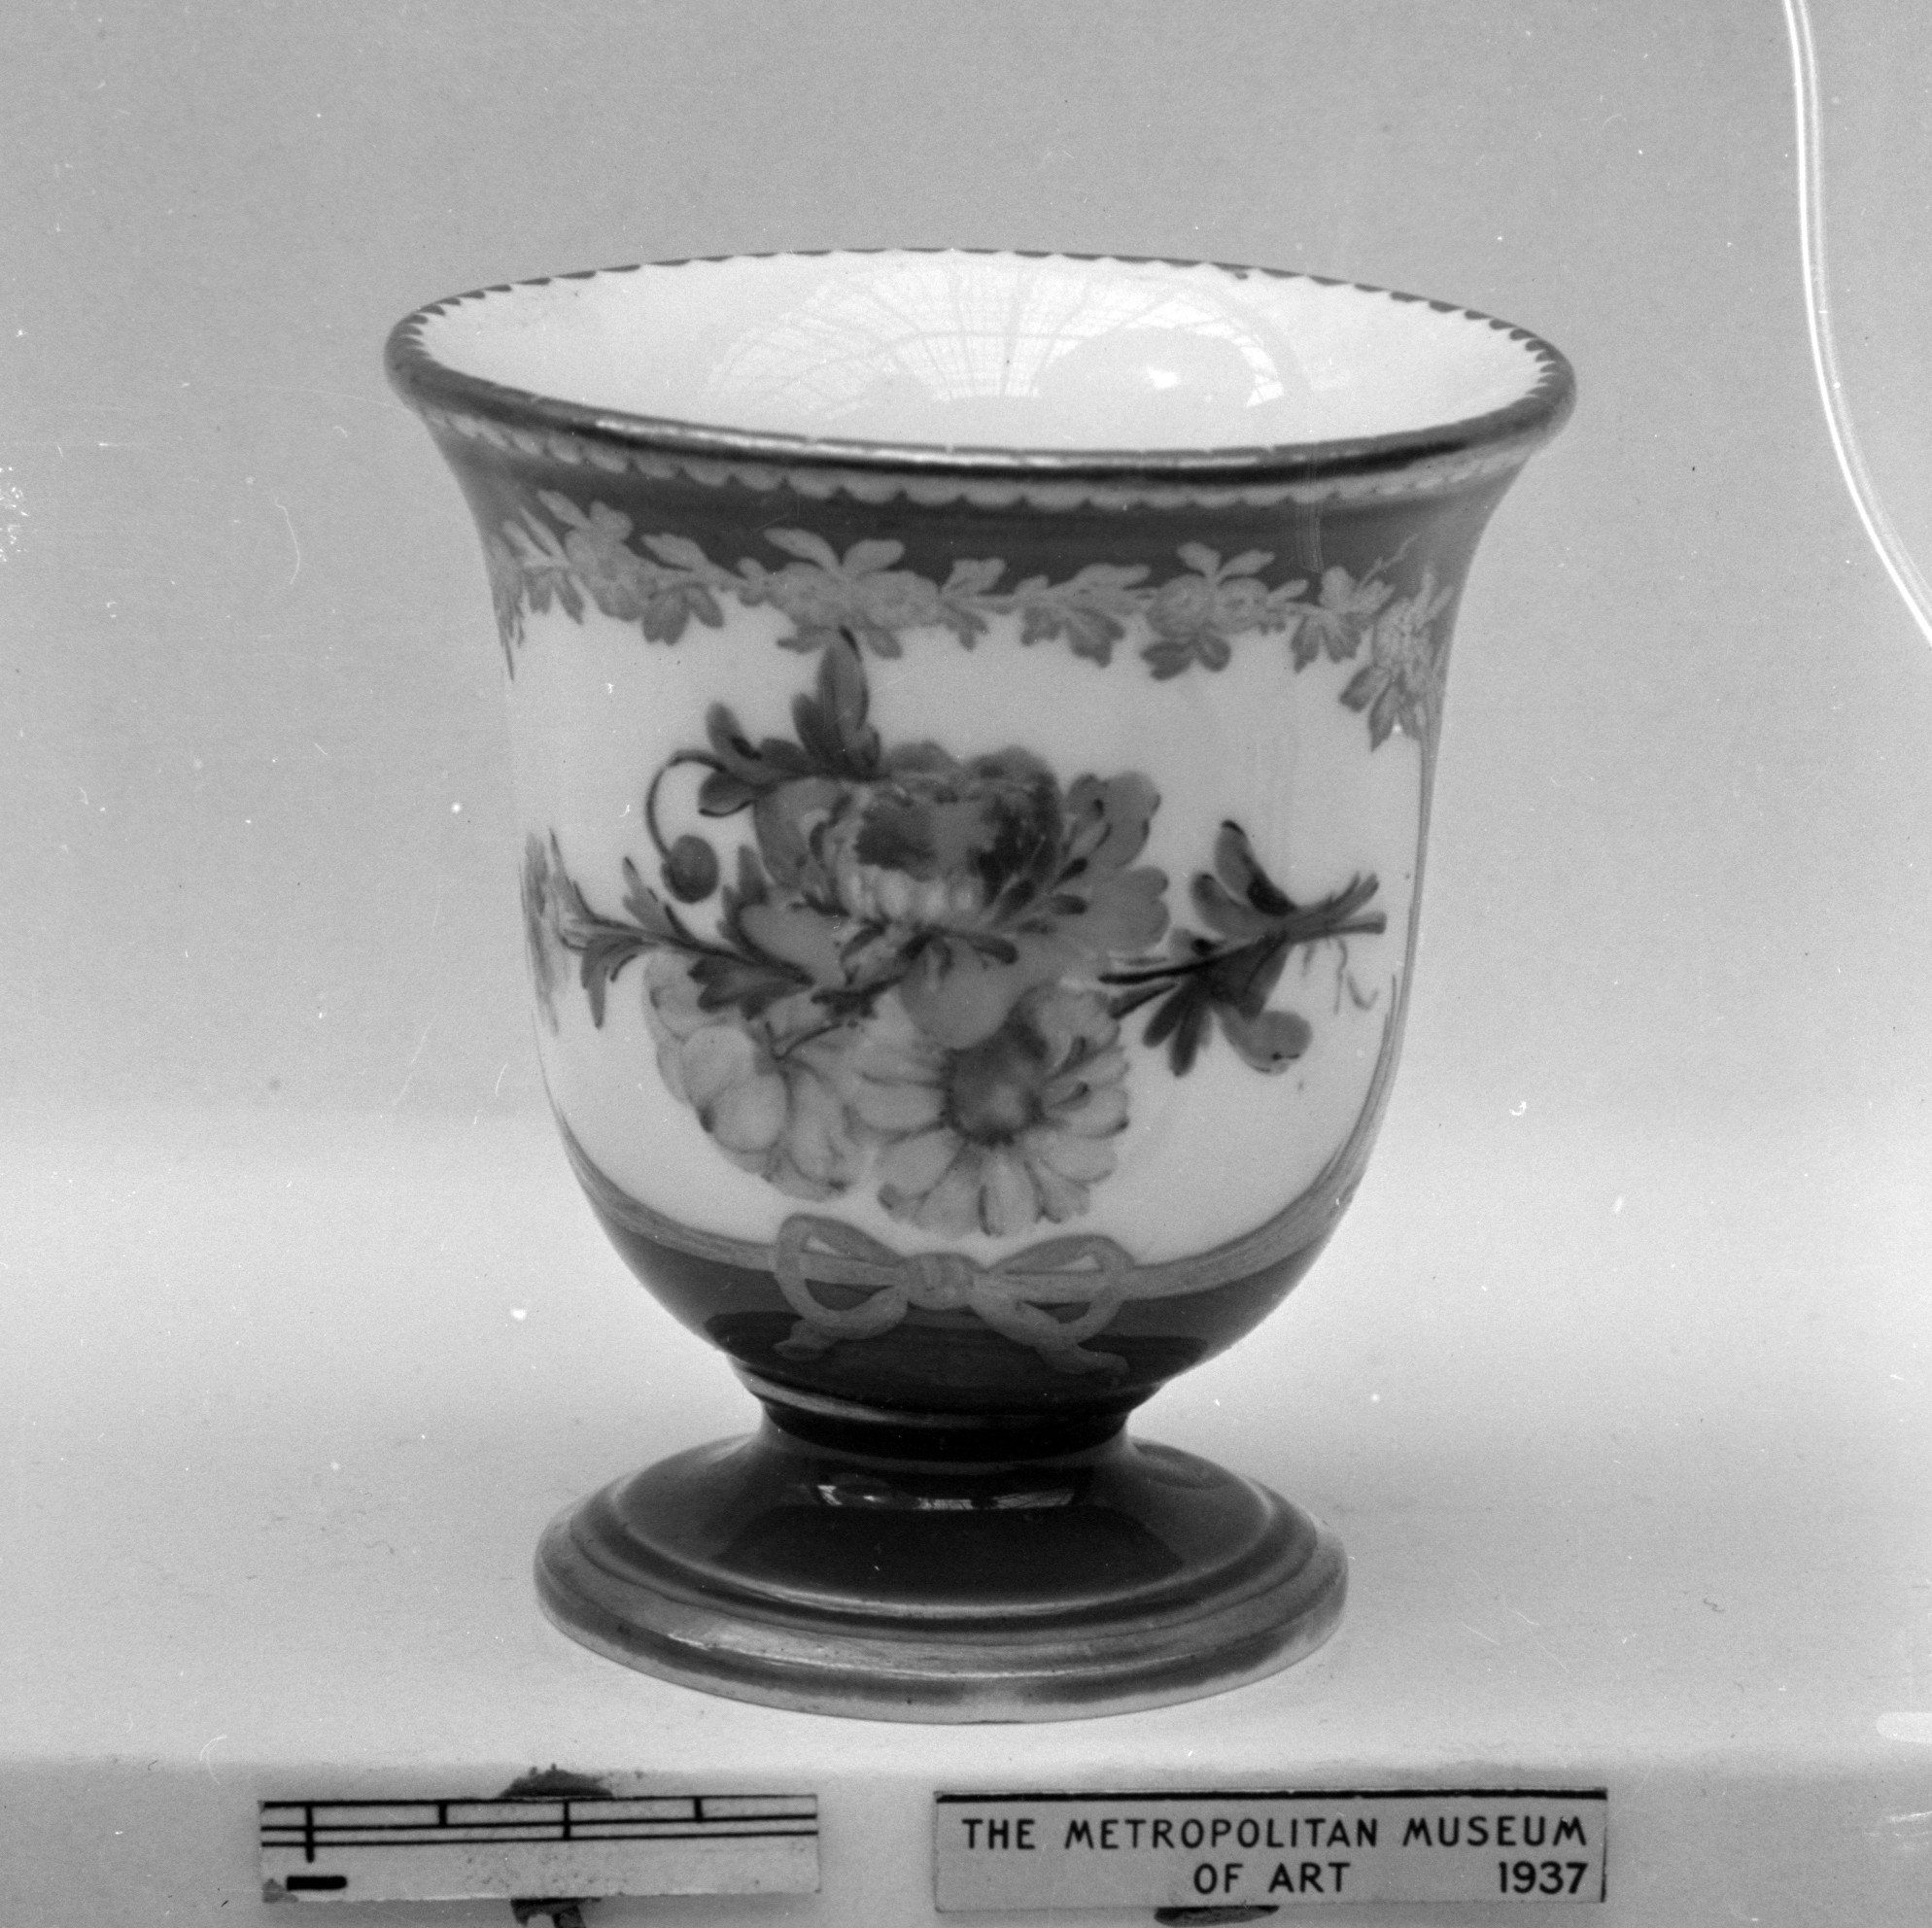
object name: ice cream cup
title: Ice cream cup (Tasse à glace) (part of a service)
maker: sèvres manufactory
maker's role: manufactory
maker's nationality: french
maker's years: 1740-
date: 1780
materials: soft paste porcelain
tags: flowers